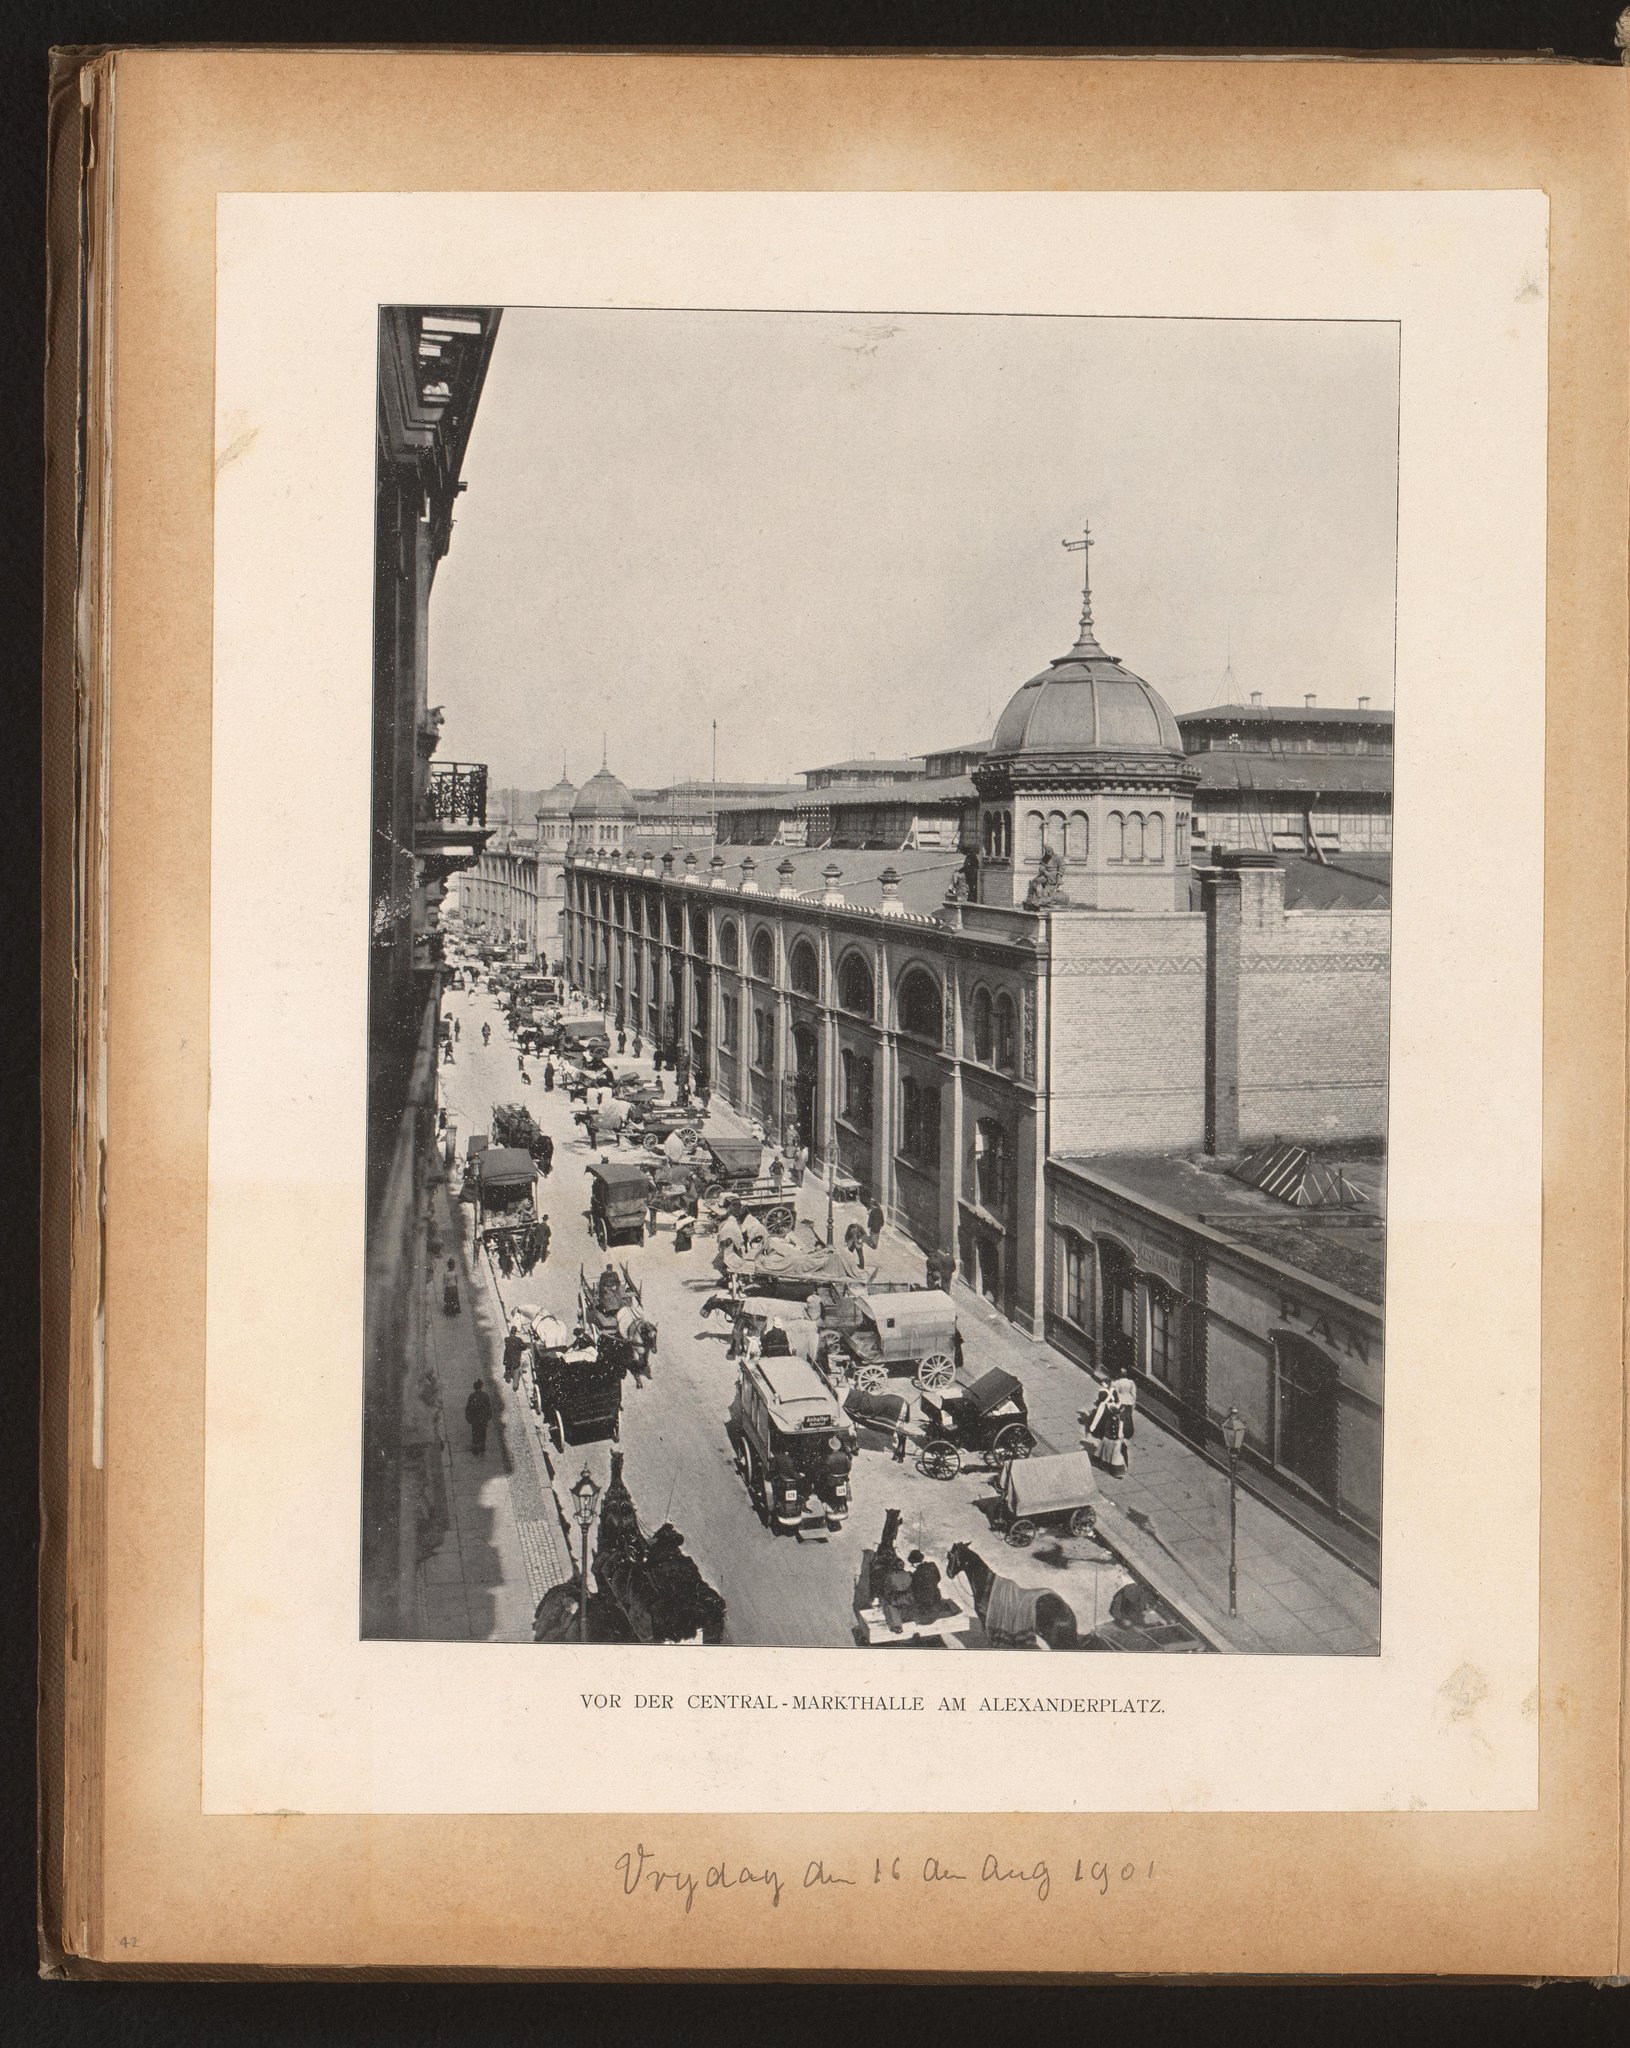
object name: album leaf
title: Gezicht op de Kaiser-Wilhelm-Strasse en de markthallen, Berlijn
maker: Anonymous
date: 1896-1901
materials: paper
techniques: autotype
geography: berlin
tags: street, market-hall, berlin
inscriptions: title: ‘Vor der Central-Markthalle am Alexanderplatz.’, inscription: ‘Vrijdag den 16de Aug 1901’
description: Deze fotomechanische afdruk maakt deel uit van een album.